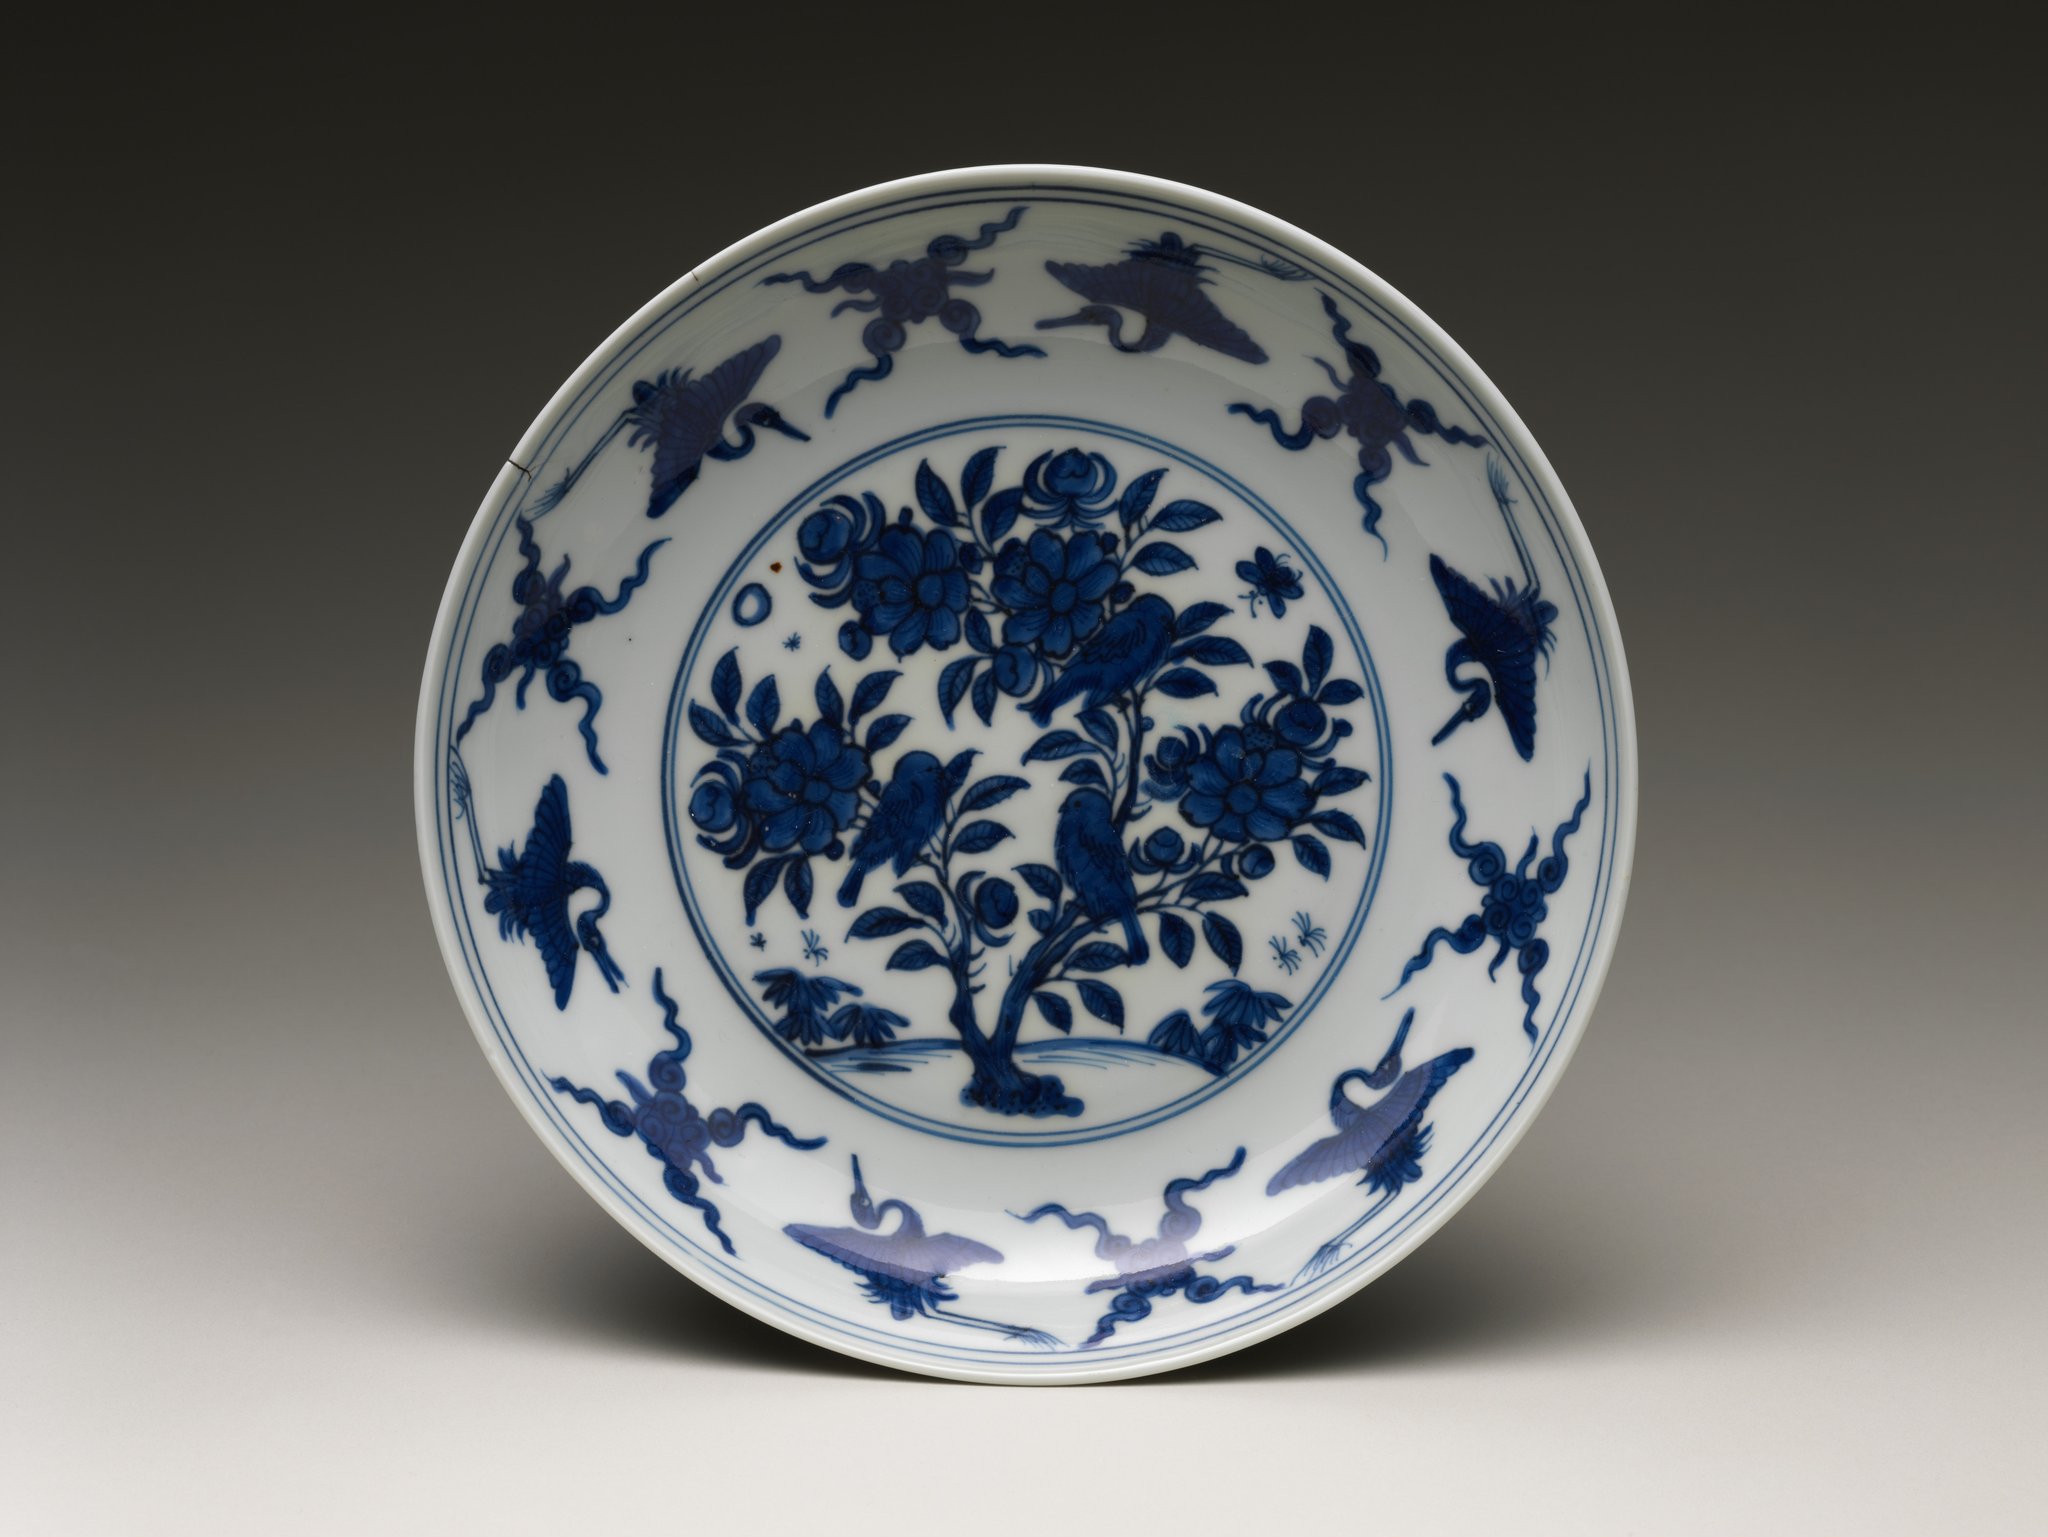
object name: dish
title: Dish with Flowers and Birds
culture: chinese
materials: cobalt, glaze, porcelain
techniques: painting